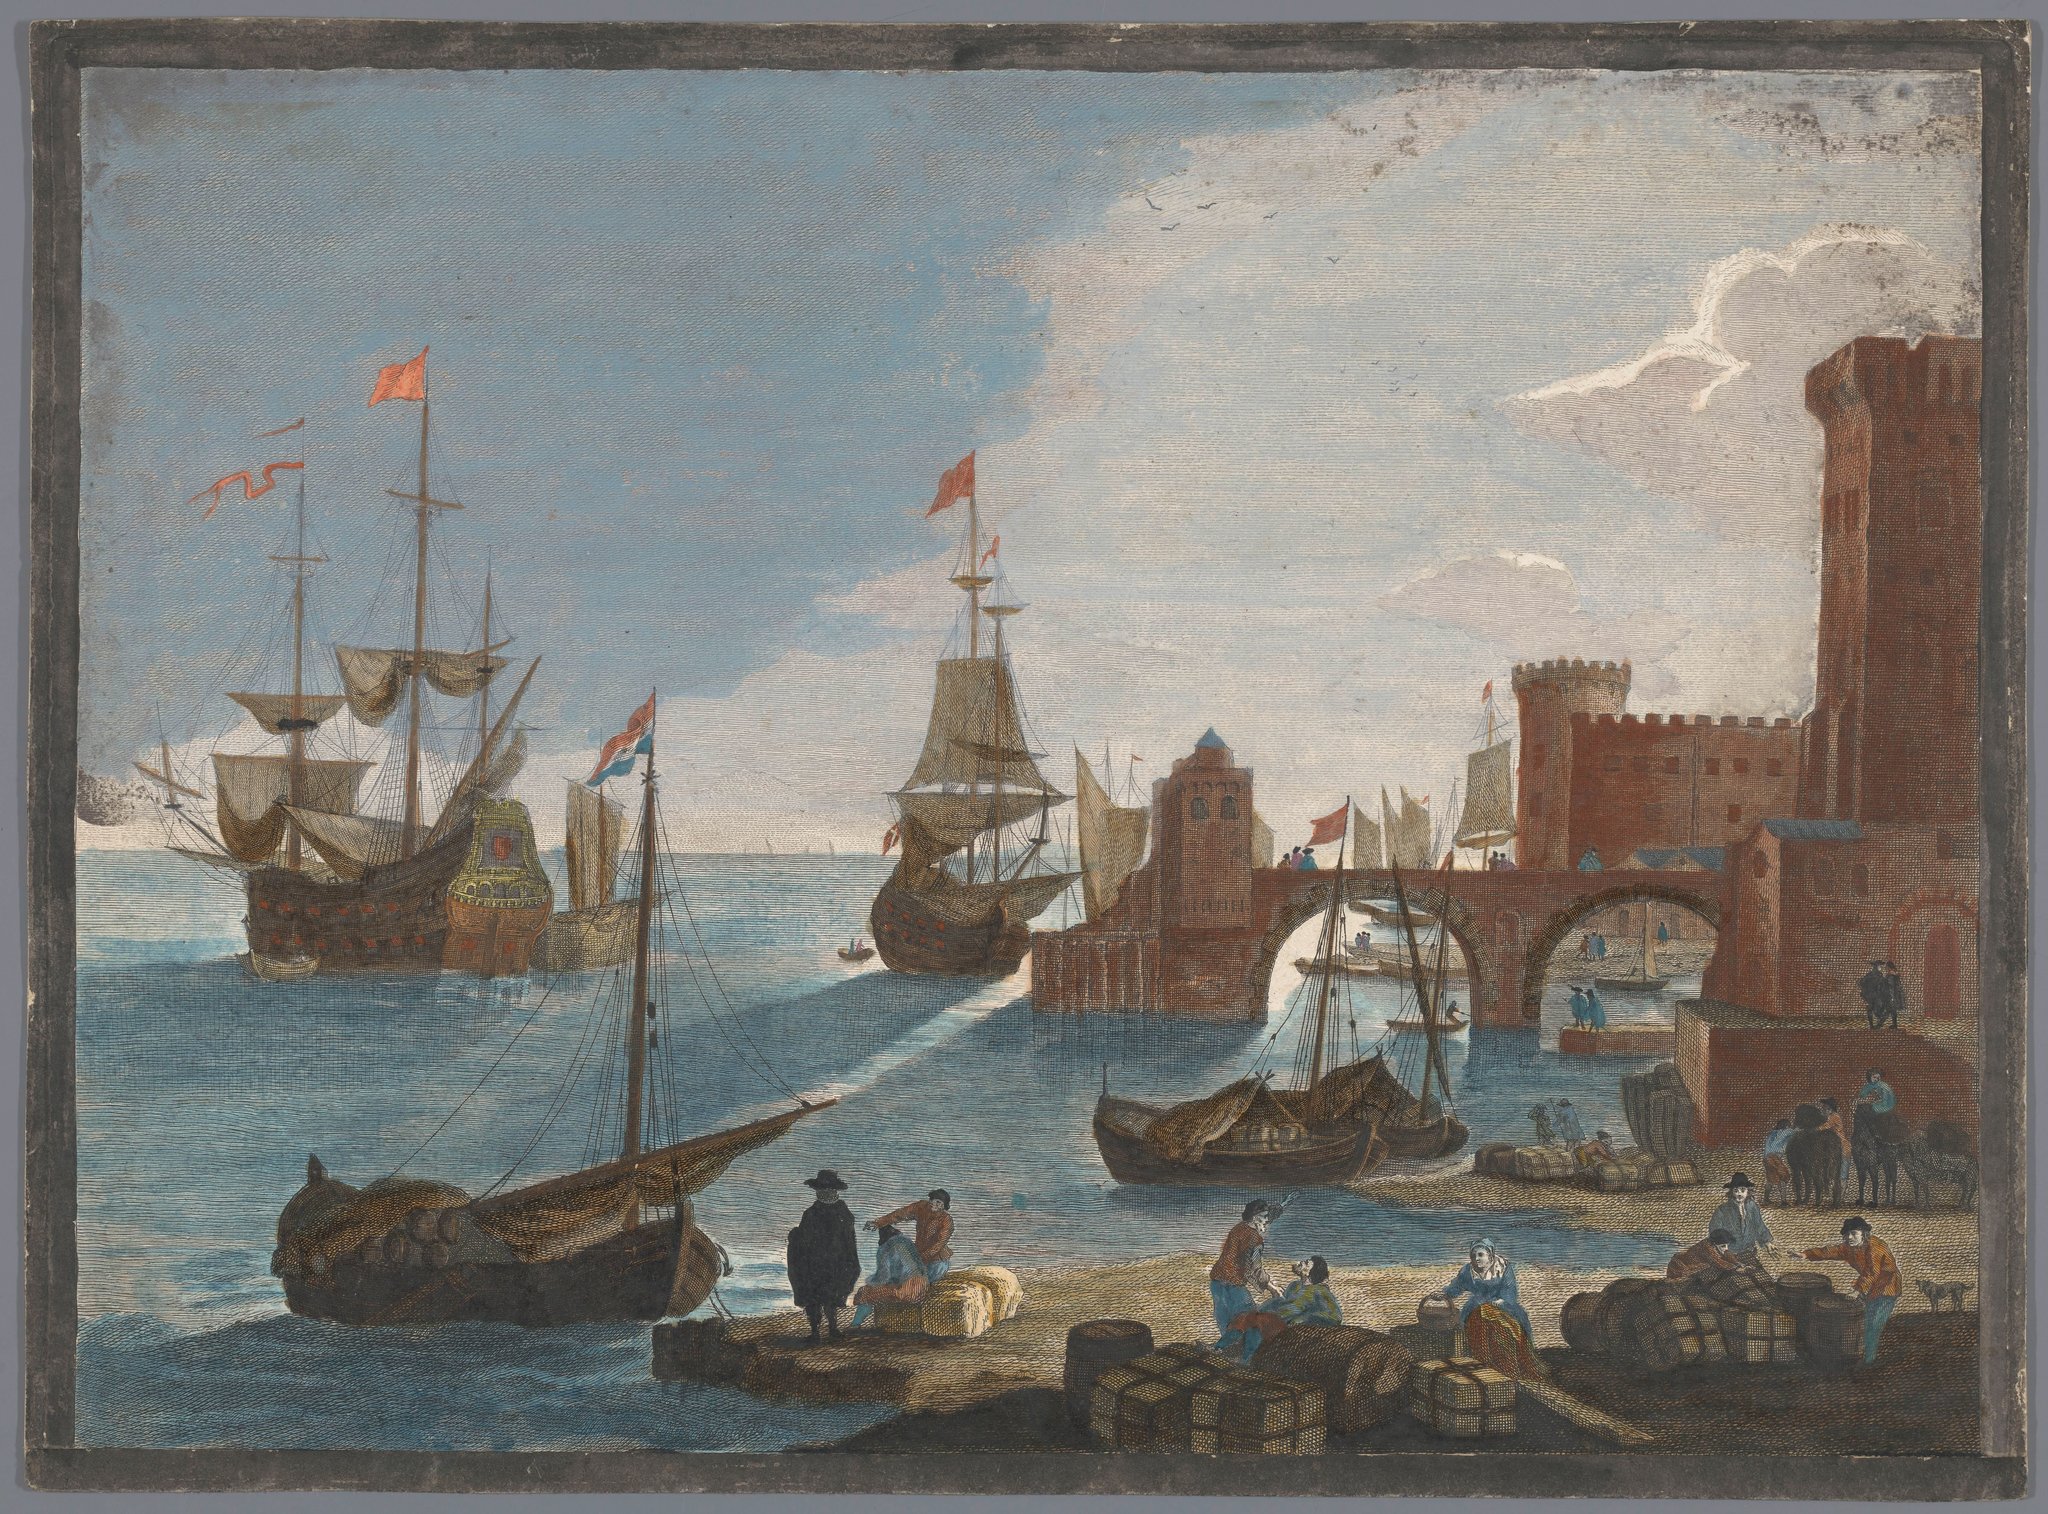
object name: opticaprent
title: 11e. Vüe maritime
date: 1753-1797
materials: cardboard, paper, watercolor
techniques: brush, etching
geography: paris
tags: harbour, sailing-ship, sailing-boat, rowing-boat, canoe, etc., sea (seascape) (+ landscape with figures, staffage), civic architecture; edifices; dwellings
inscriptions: collector's mark: Lugt 2233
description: Rechts een versterkt bouwwerk met een brug over het water en groepen figuren met goederen aan de waterkant. In de titel genummerd: 11.